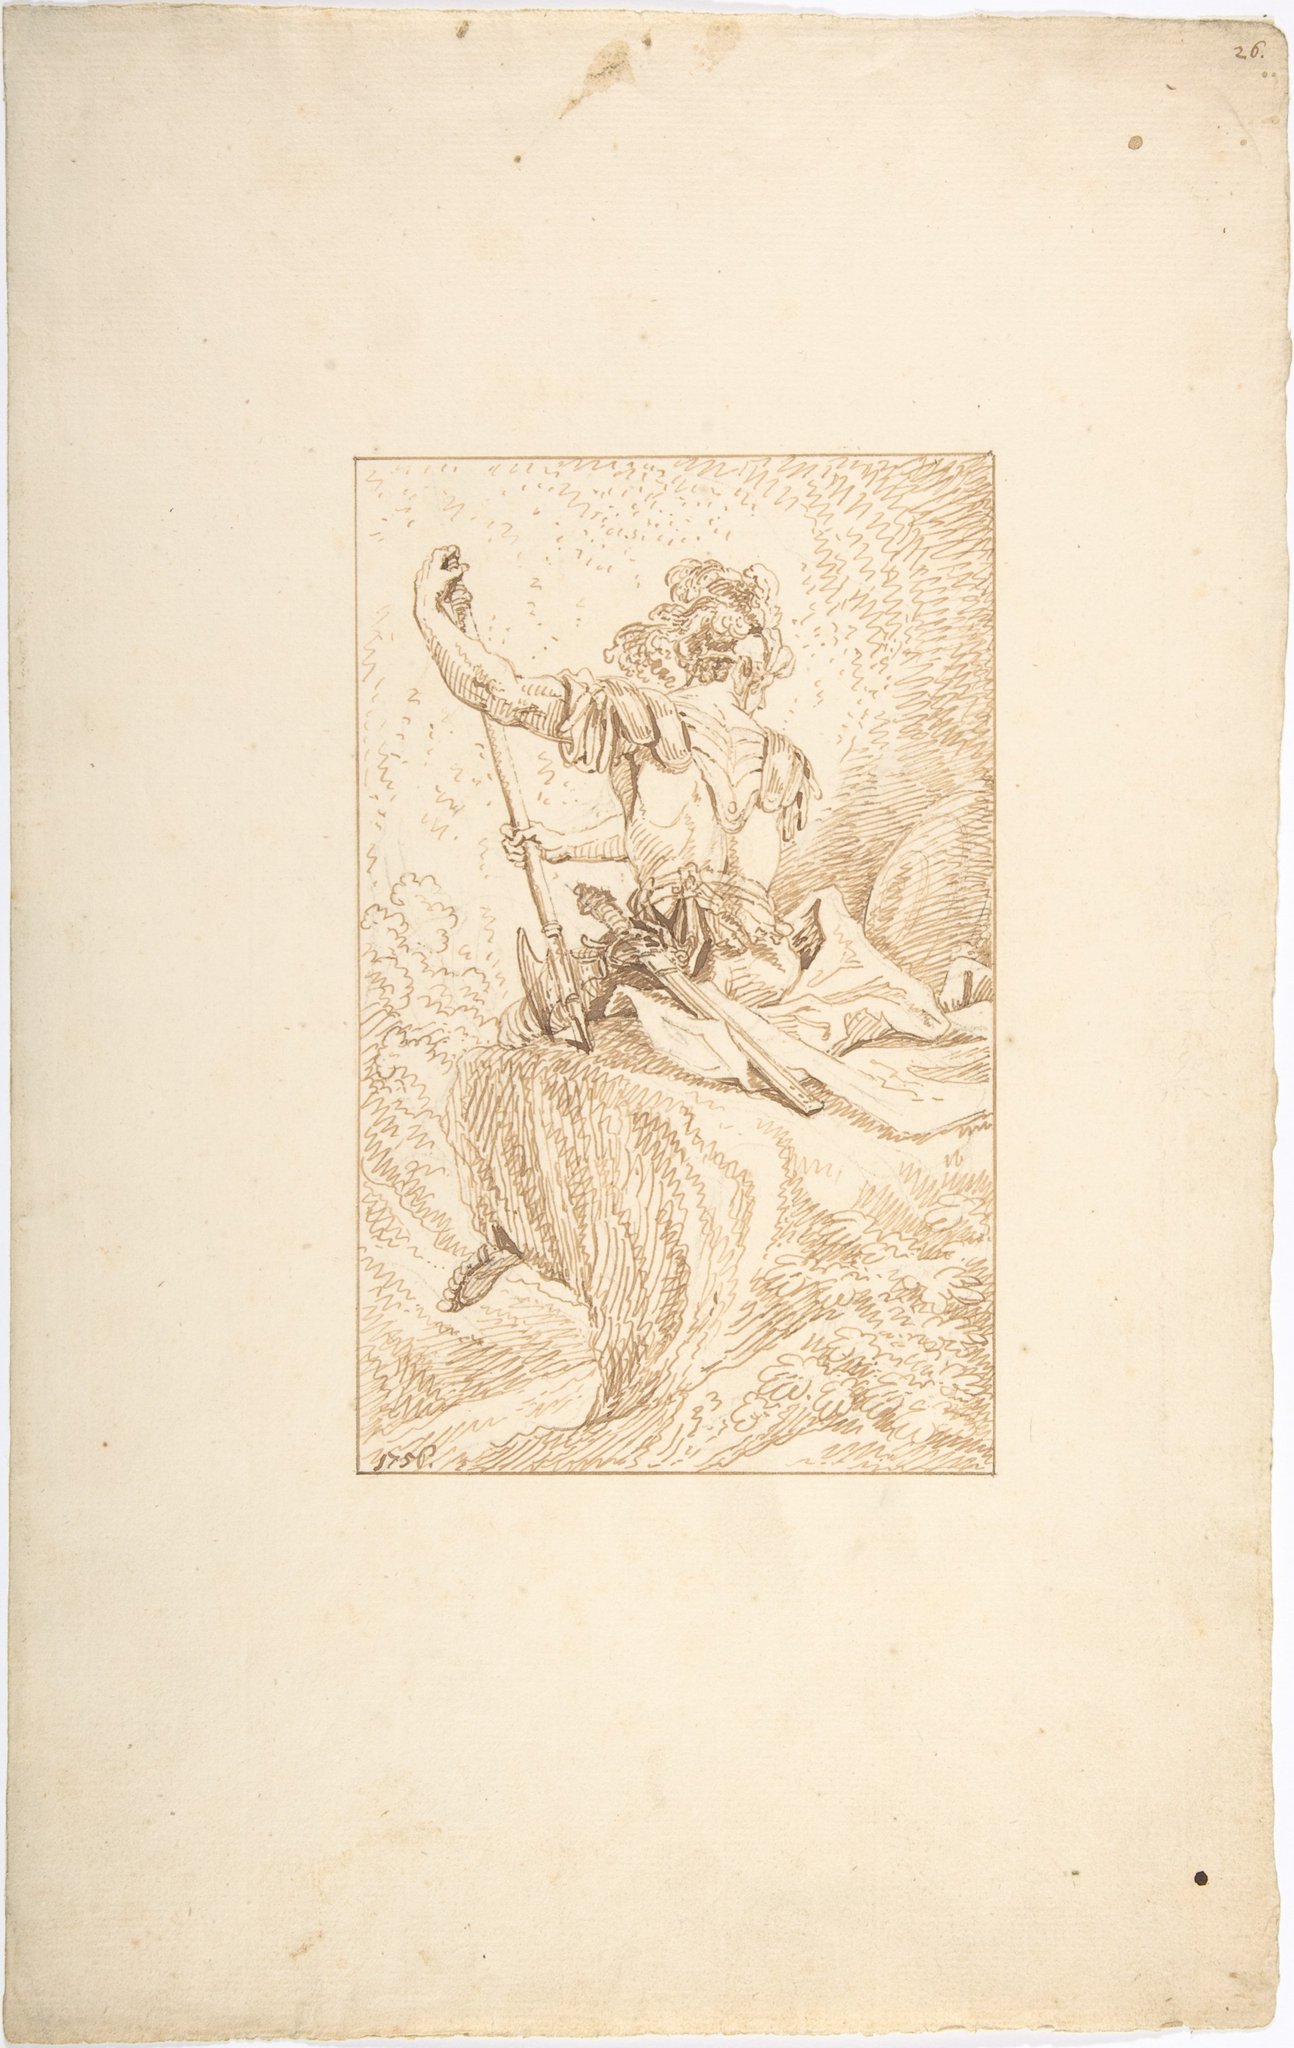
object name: drawing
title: Roman Warriors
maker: johann elias ridinger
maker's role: artist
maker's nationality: german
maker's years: 1698-1767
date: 1700-1767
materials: graphite, ink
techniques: pen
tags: soldiers,men,axes